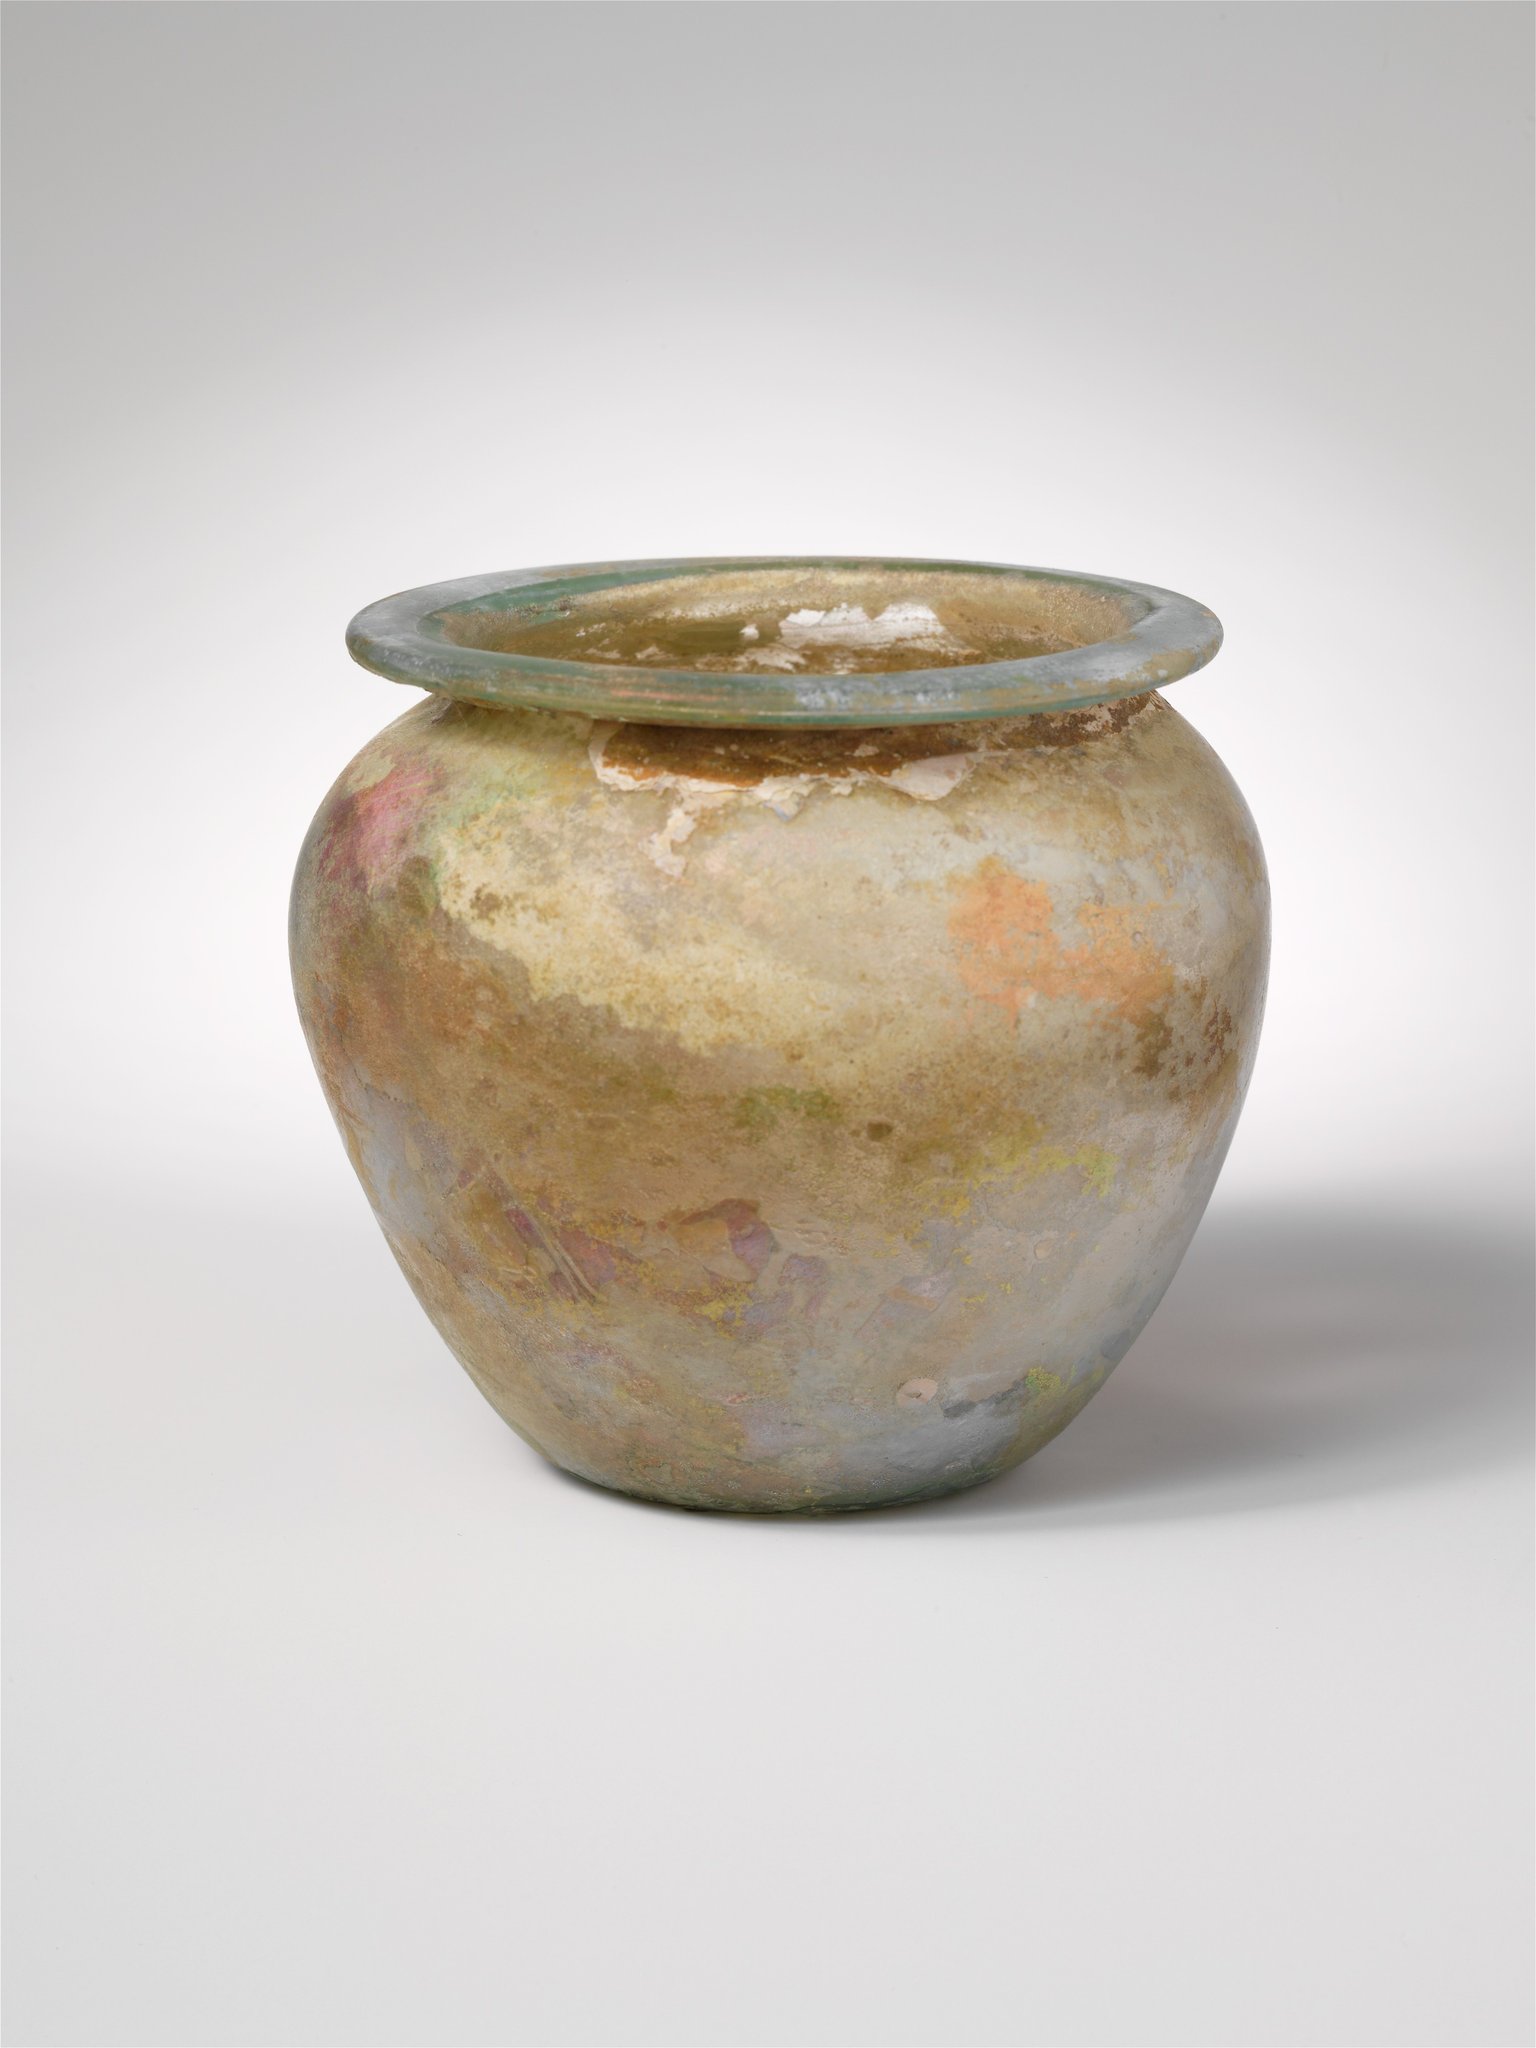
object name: jar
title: Glass jar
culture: roman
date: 34-200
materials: glass